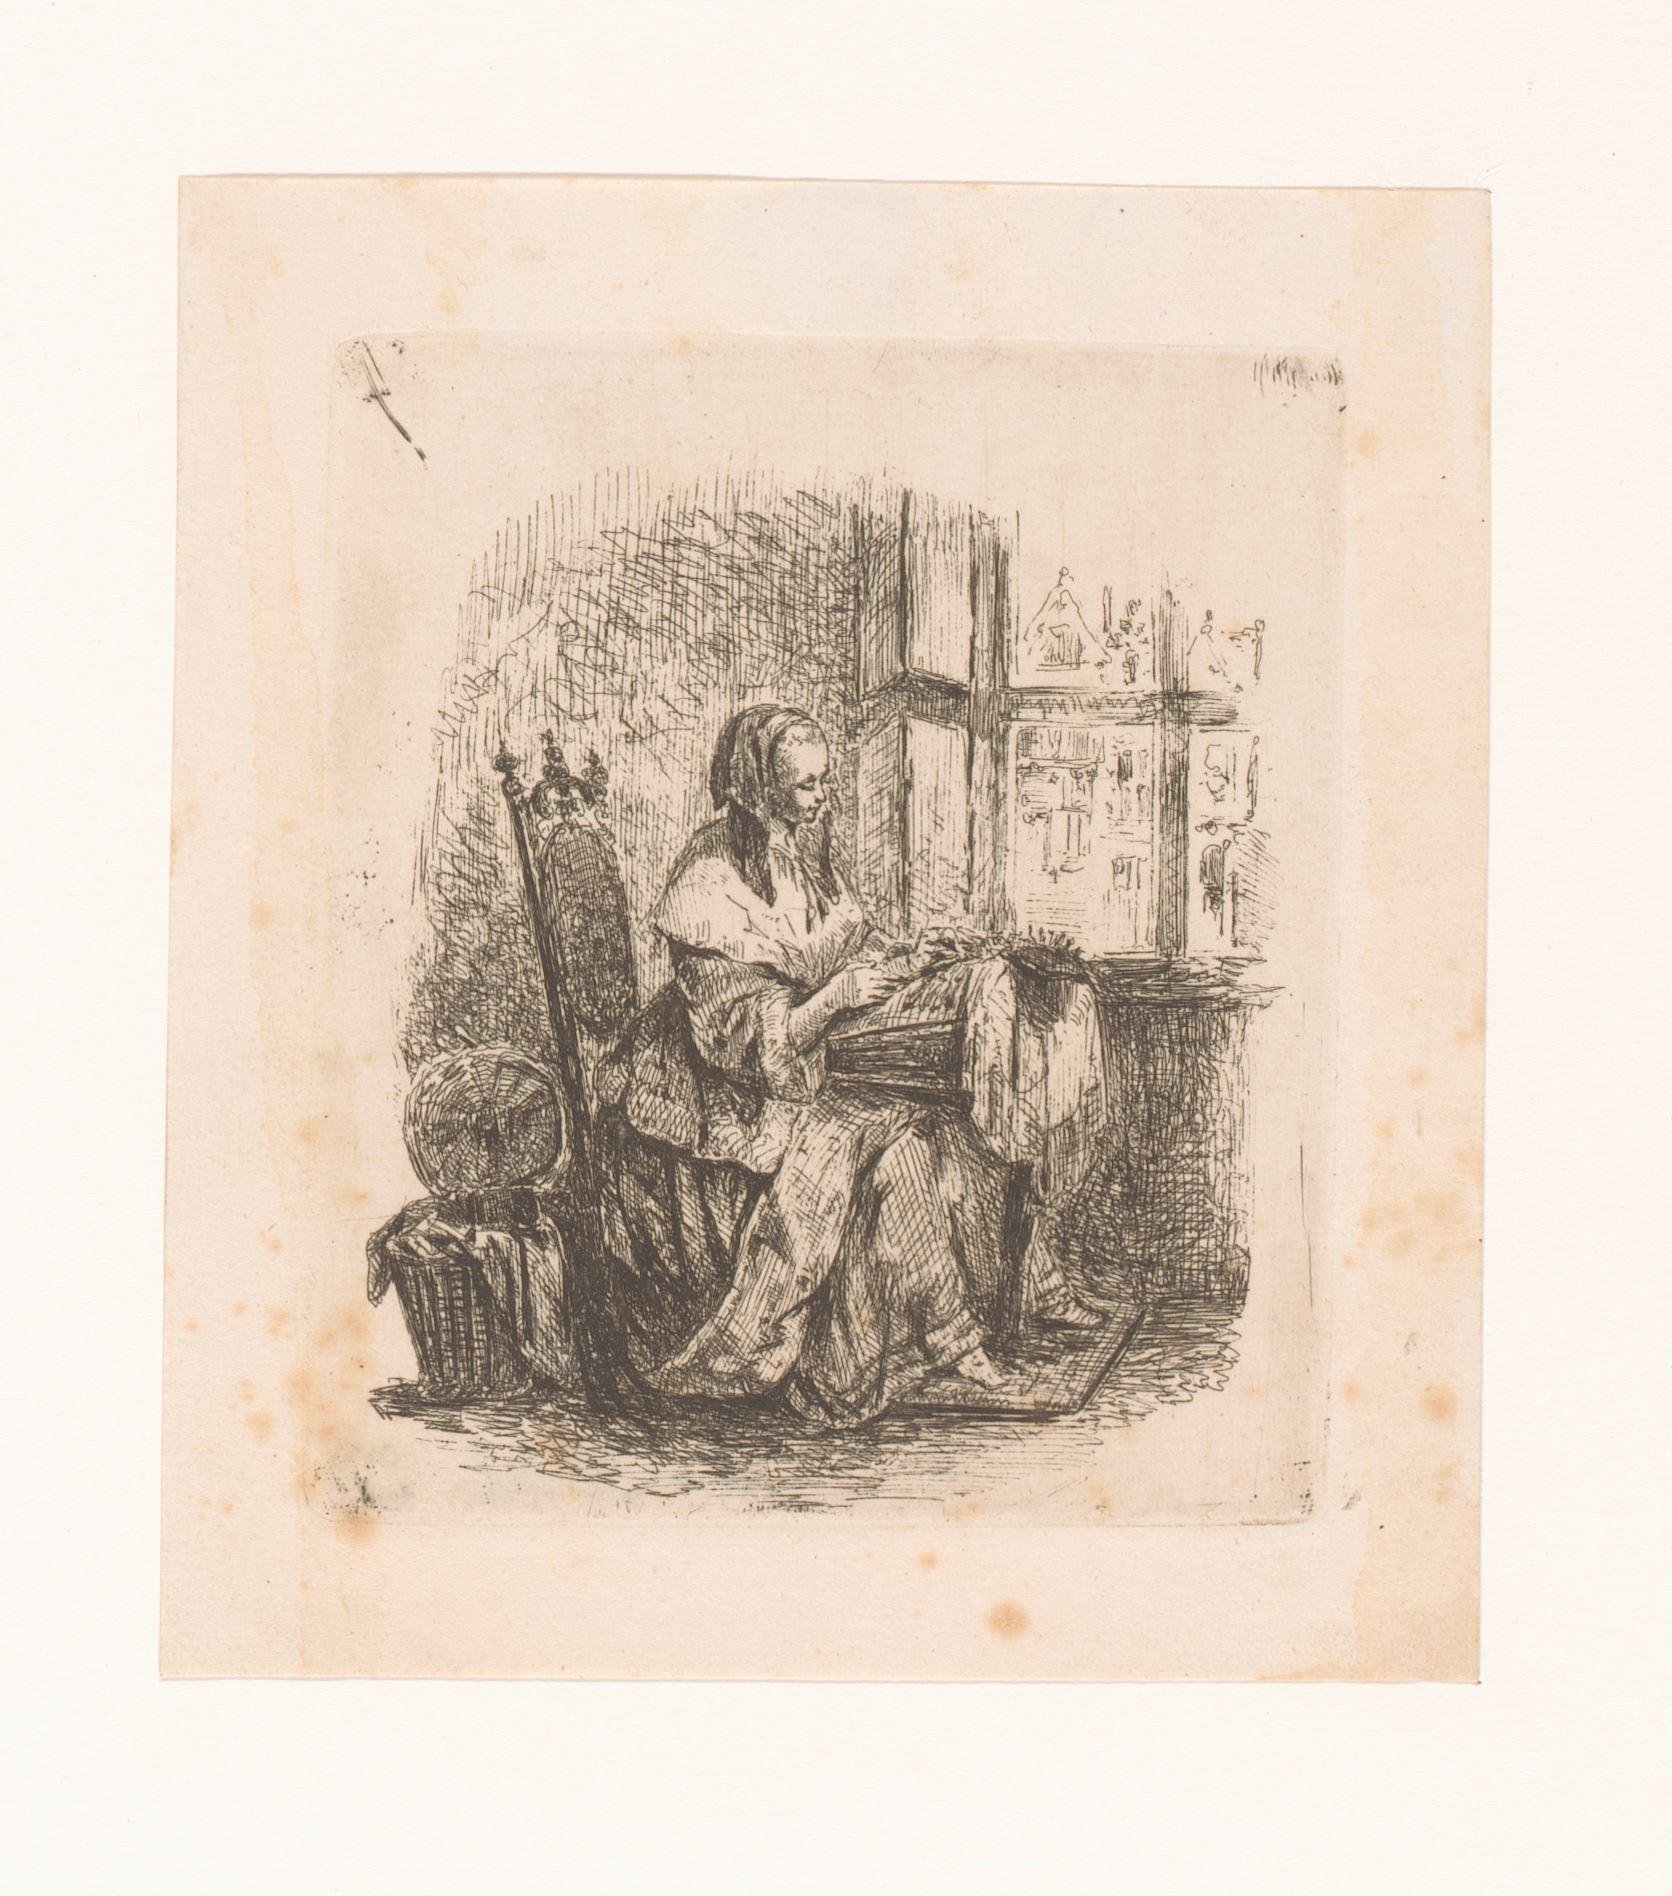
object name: print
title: Jonge kantwerkster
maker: adrien joseph verhoeven-ball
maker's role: draughtsman, print maker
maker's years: 1824-1882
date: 1834-1882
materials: paper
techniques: drypoint, etching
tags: lace-making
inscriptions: collector's mark: Lugt 2228, collector's mark: Lugt 1485